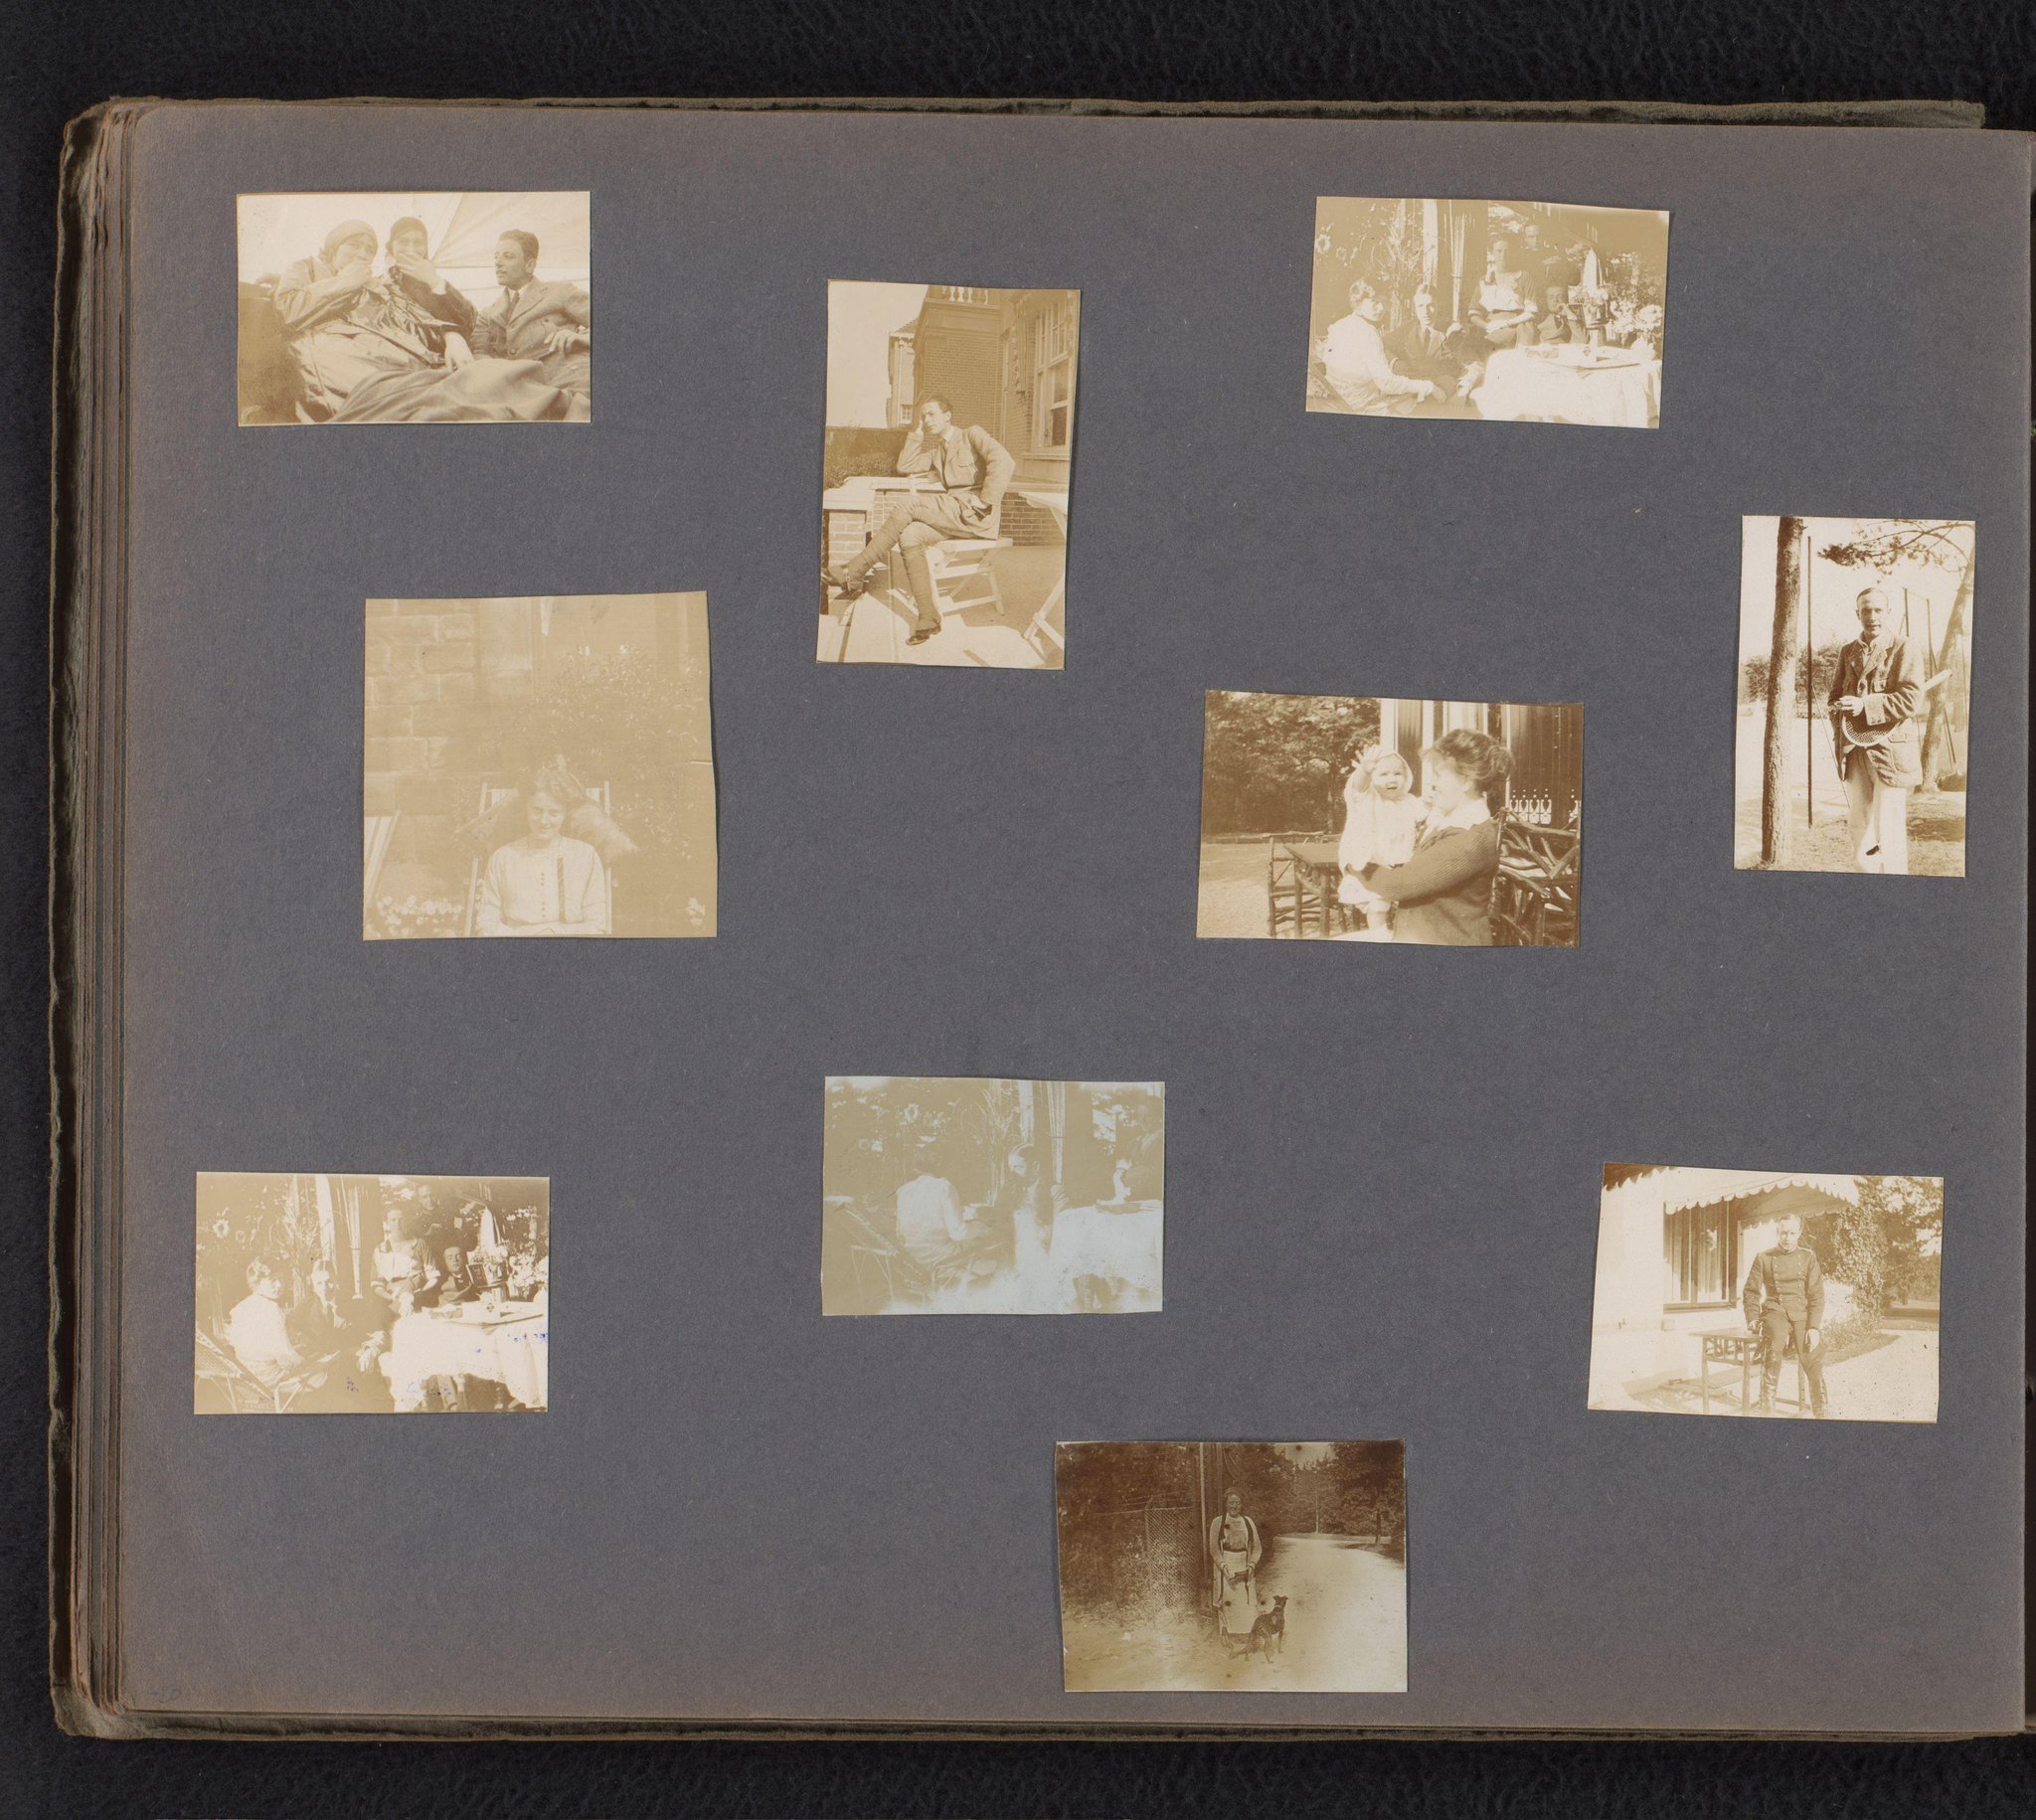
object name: photograph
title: Familie en vrienden van het gezin Onnen-van den Berg in een tuin, op een boot en bij een tennisbaan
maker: Anonymous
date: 1913-1914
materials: paper, cardboard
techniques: gelatin silver print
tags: tennis, lawn-tennis, sailing-ship, sailing-boat, garden, family life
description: Deze foto's zijn onderdeel van een album.